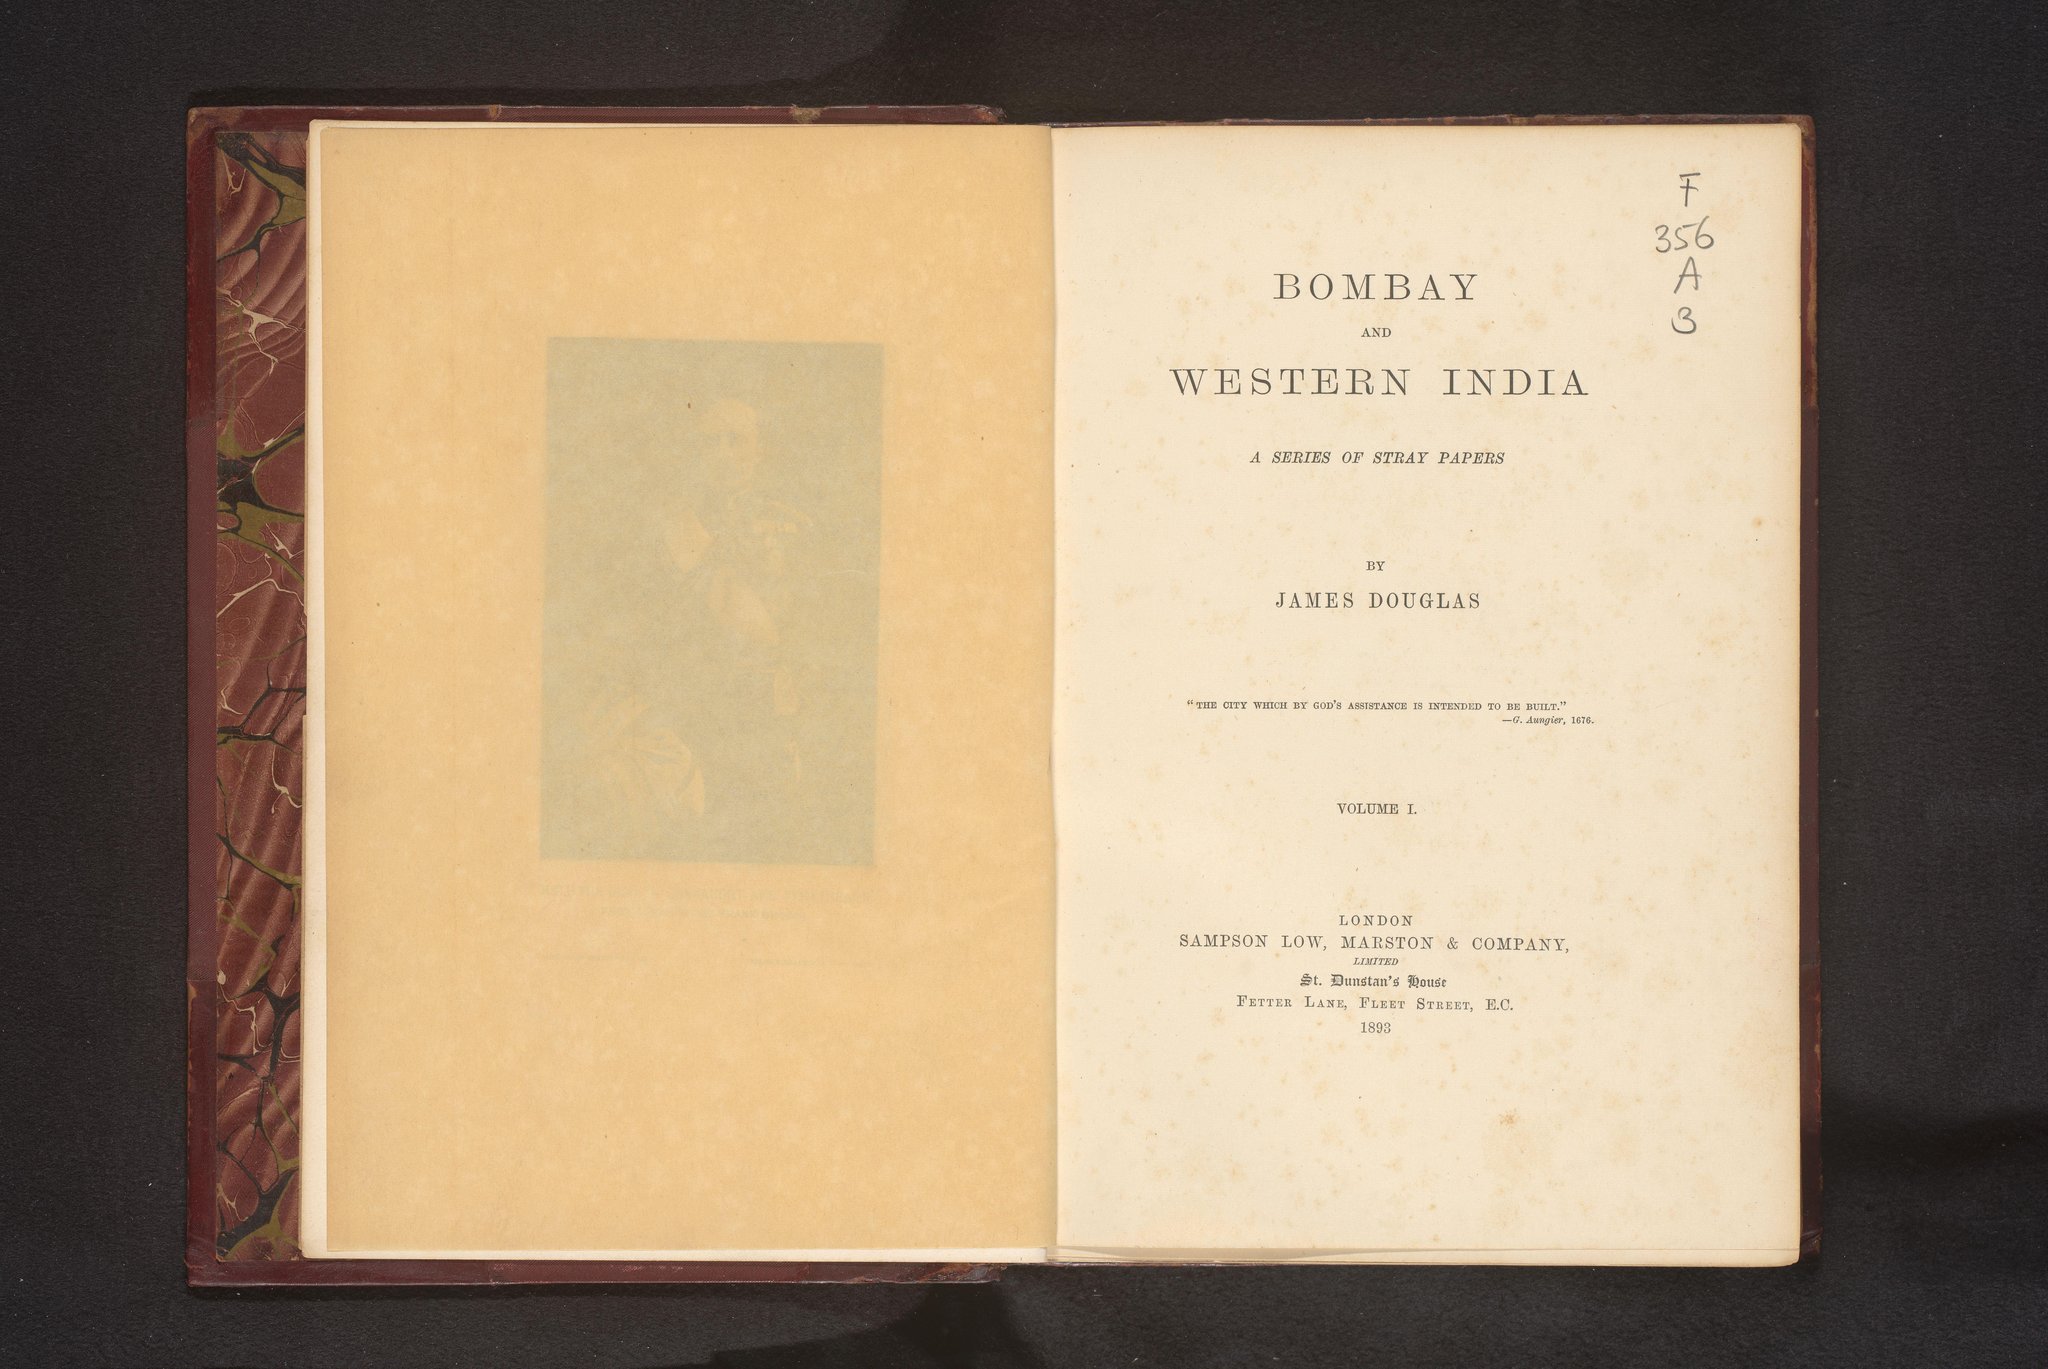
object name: book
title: Bombay and Western India : a series of stray papers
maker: james douglas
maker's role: auteur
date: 1893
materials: cardboard, leather, linen, paper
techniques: lithograph, marbling, photoaquatint, printing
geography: london